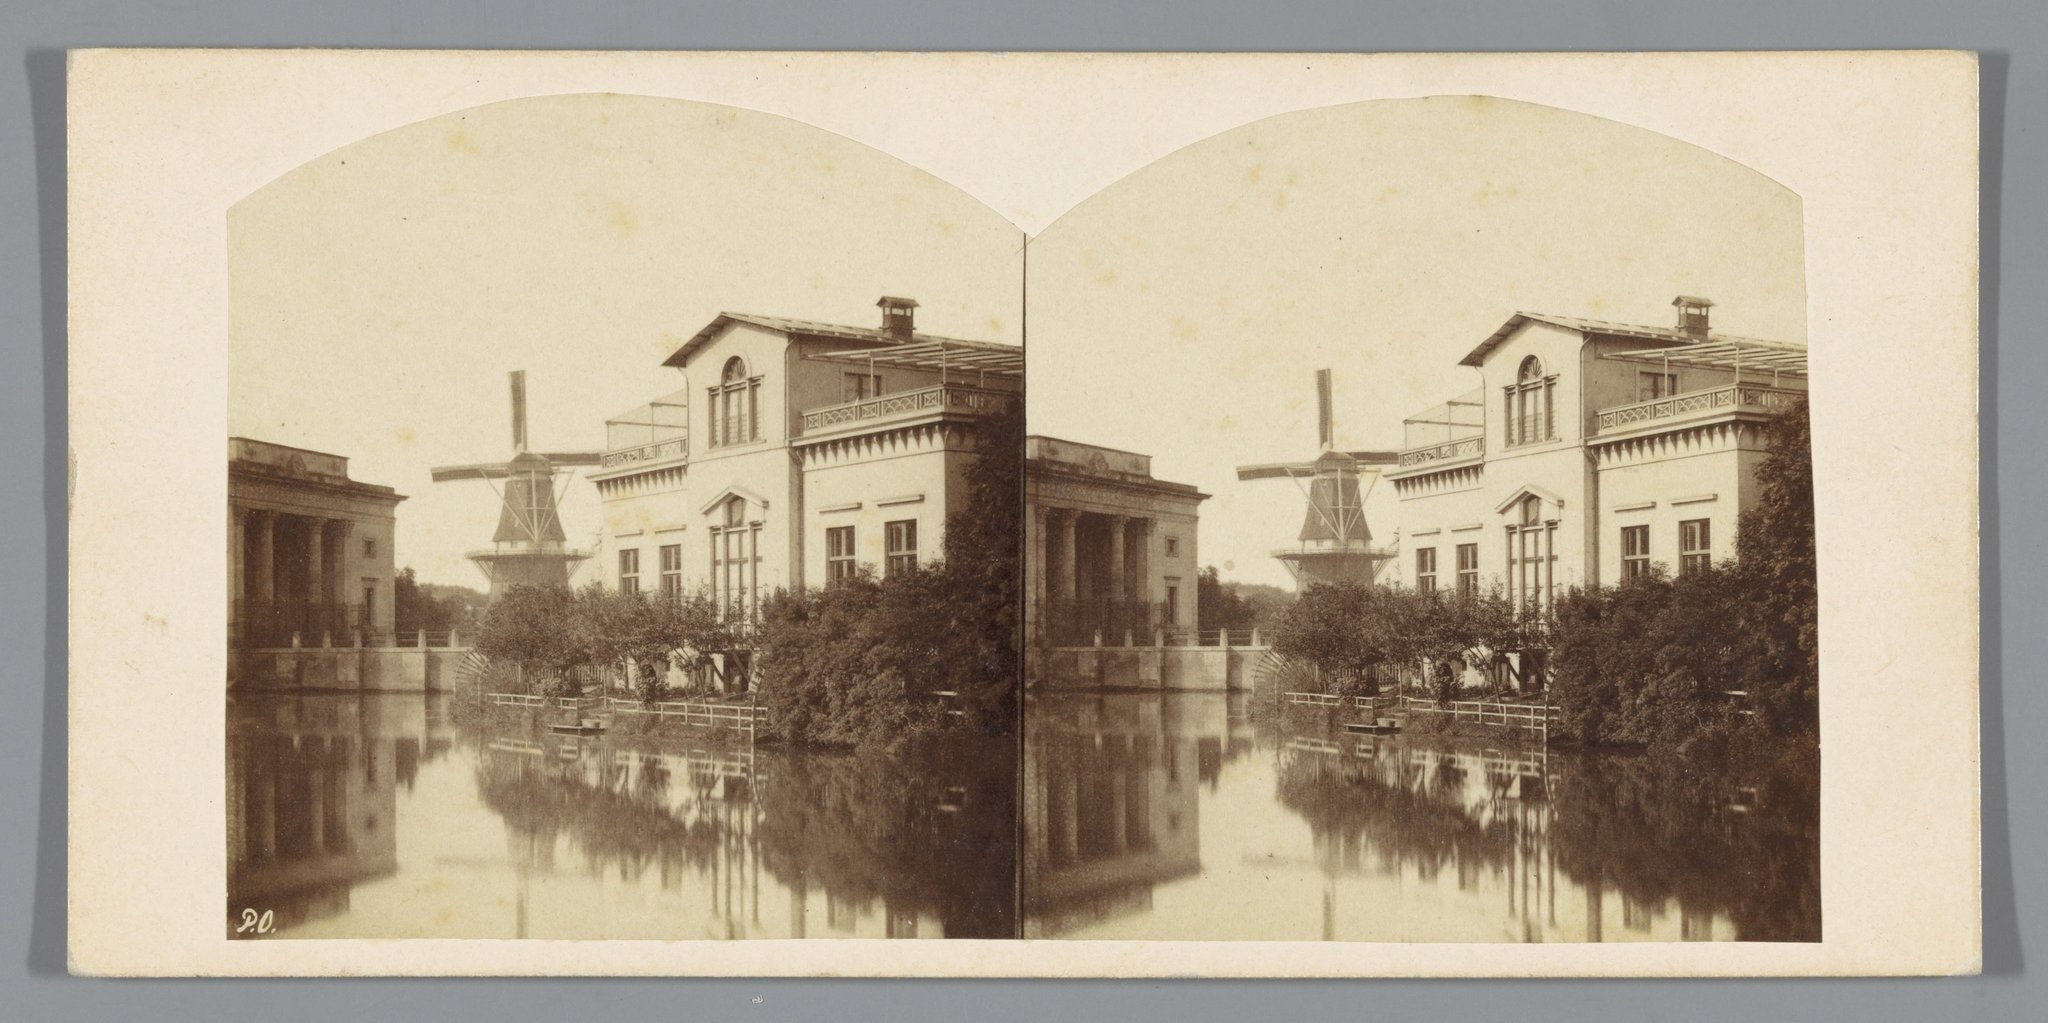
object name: stereograph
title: Haarlemmerpoort en molen De Kraay, Amsterdam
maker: pieter oosterhuis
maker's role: draughtsman, print maker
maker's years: 1816-1885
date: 1859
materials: cardboard, paper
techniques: albumen print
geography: amsterdam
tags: canals, waters (in city), windmill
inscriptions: initials: ‘P.O.’, inscription: ‘foto Pieter Oosterhuis/ uitgegeven A. Jager/ gephotographiëerd augustus 1859’